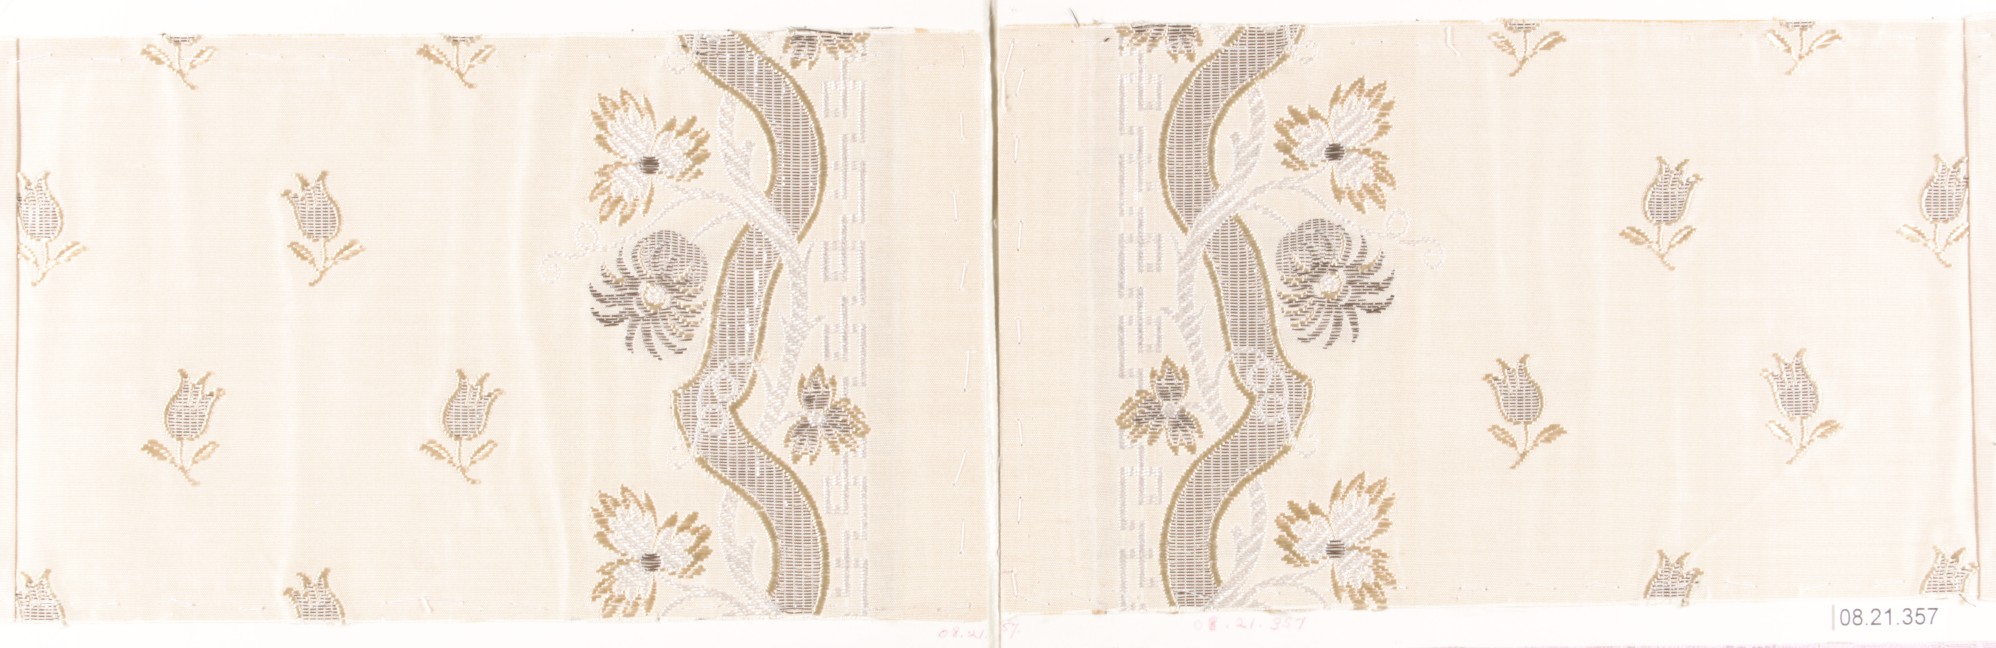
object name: textile sample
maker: Anonymous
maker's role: designer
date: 1900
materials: silk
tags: flowers